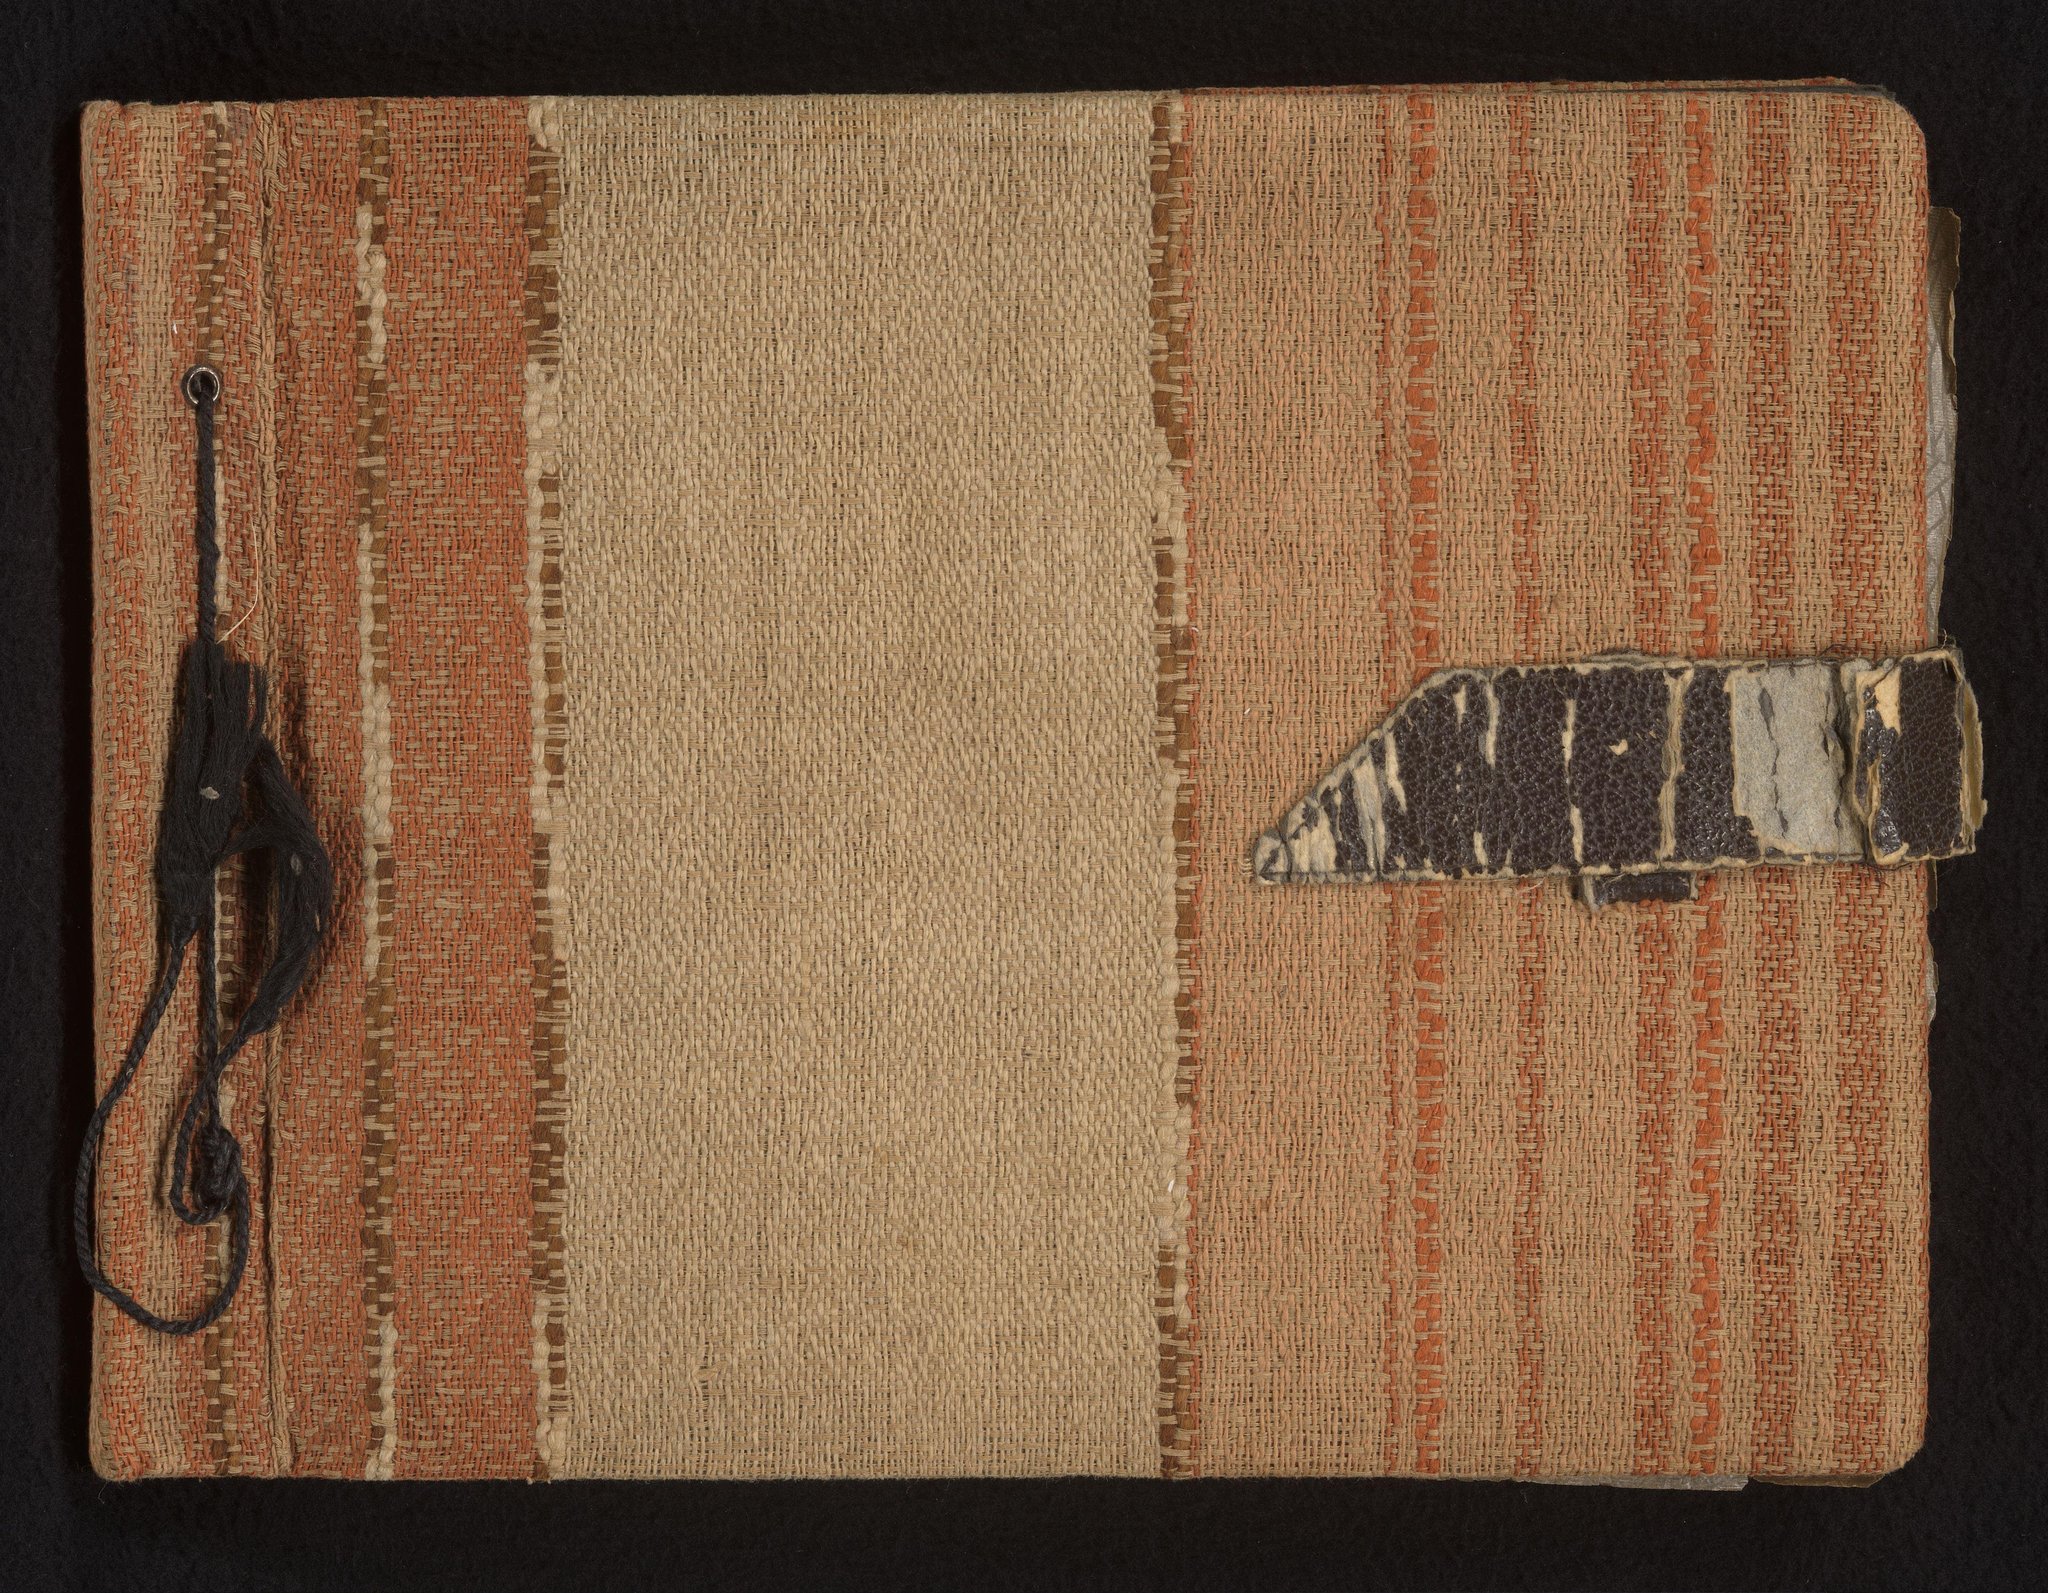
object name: photograph album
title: Kriegszeit in Holland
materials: paper, photographic support, textile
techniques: gelatin silver print, writing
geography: netherlands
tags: netherlands, rotterdam, rotterdam blitz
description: Fotoalbum in band bekleed met weefsel in bruin en oranje en sluitingsriempje. Samengesteld door een lid van een Flak Regiment van de Luftverteidigungskommando van de Luftwaffe. Wachtmeister Hans Heinemann (zie foto's van de samensteller op pagina 1 en 8). Het album bevat 24 bladen van bruin papier met in totaal 148 foto's, een krantenknipsel en een theaterprogramma. De foto's tonen vooral beelden van het verwoeste Rotterdam, in brand staande olietanks en vernielde schepen. Daarnaast foto's van de stelling nabij de kust waar Heinemann gelegerd was. Bij veel van de foto's staan opschriften. Bij het album zitten 6 documenten die betrekking hebben op verlof en reizen van Heinemann terug naar Duitsland in januari-maart 1945 en twee krantenknipsels.